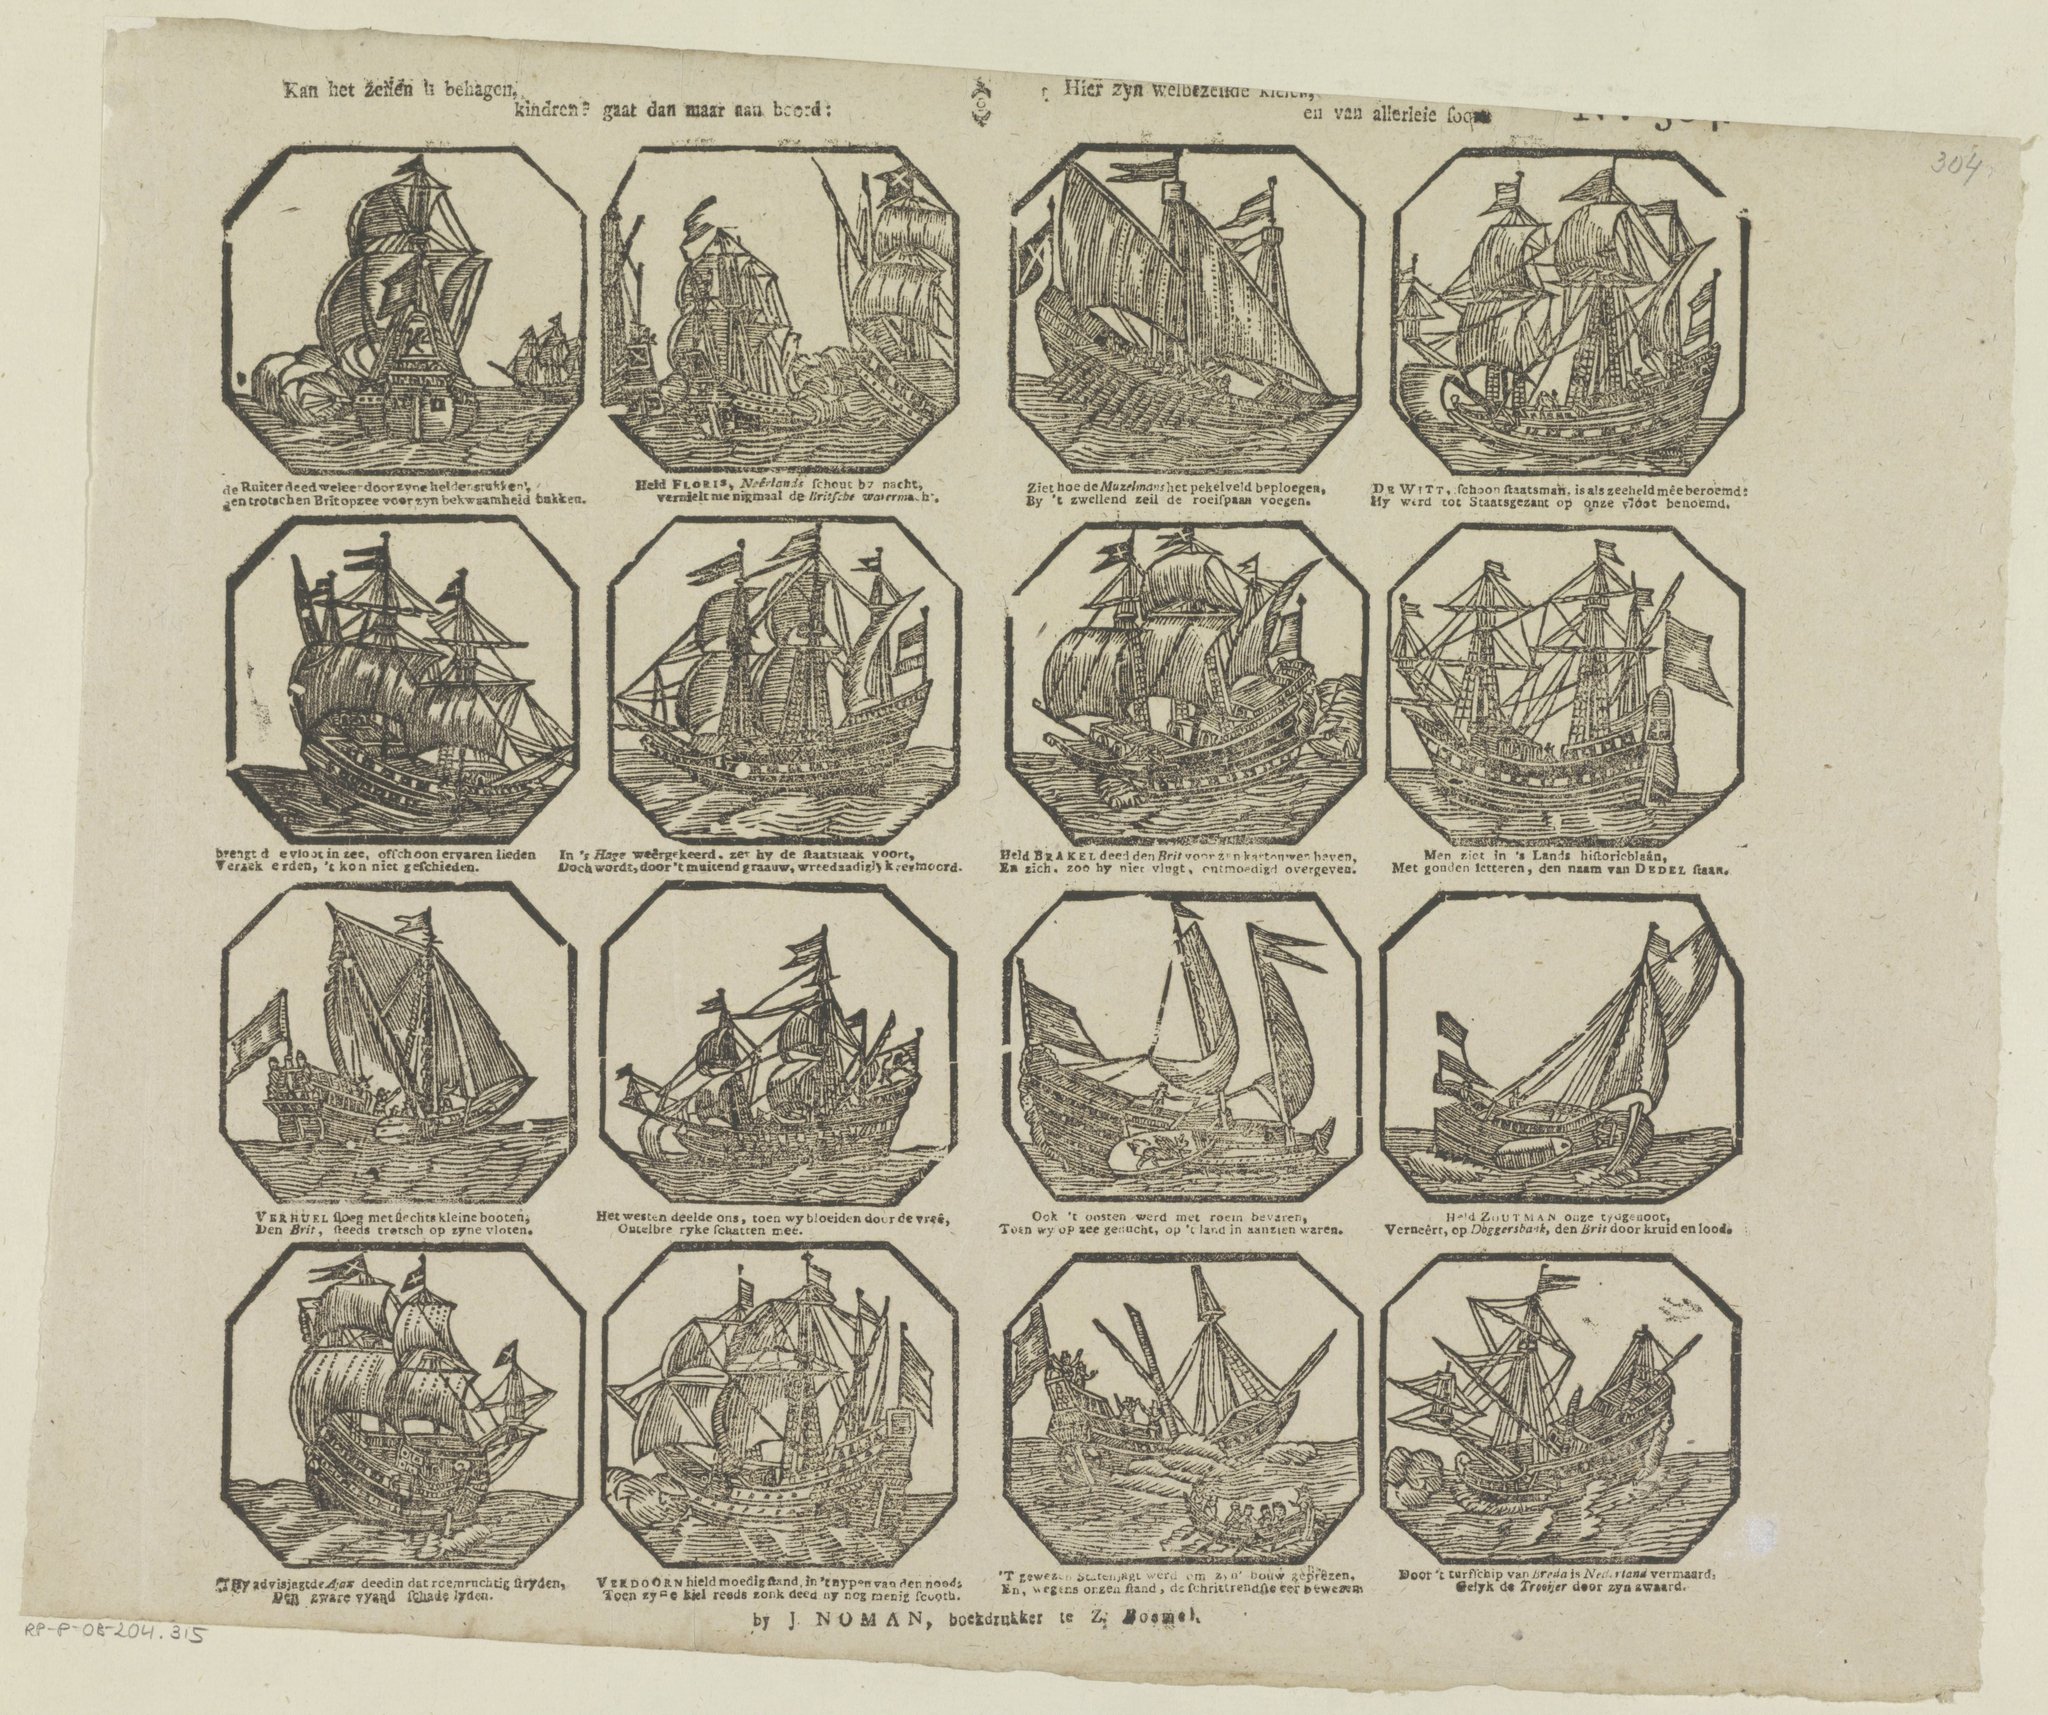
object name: print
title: Kan het zeilen u behagen, / kindren? gaat dan maar aan boord; / hier zyn welbezeilde [(...)], / en van allerleie soort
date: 1806-1830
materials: paper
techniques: letterpress printing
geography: netherlands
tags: military vehicles (+ sailing-ships), ships (in general)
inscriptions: collector's mark: Lugt 2760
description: Blad met 16 voorstellingen van verschillende schepen. Onder elke afbeelding een tweeregelig vers. Genummerd rechtsboven: No. 304.